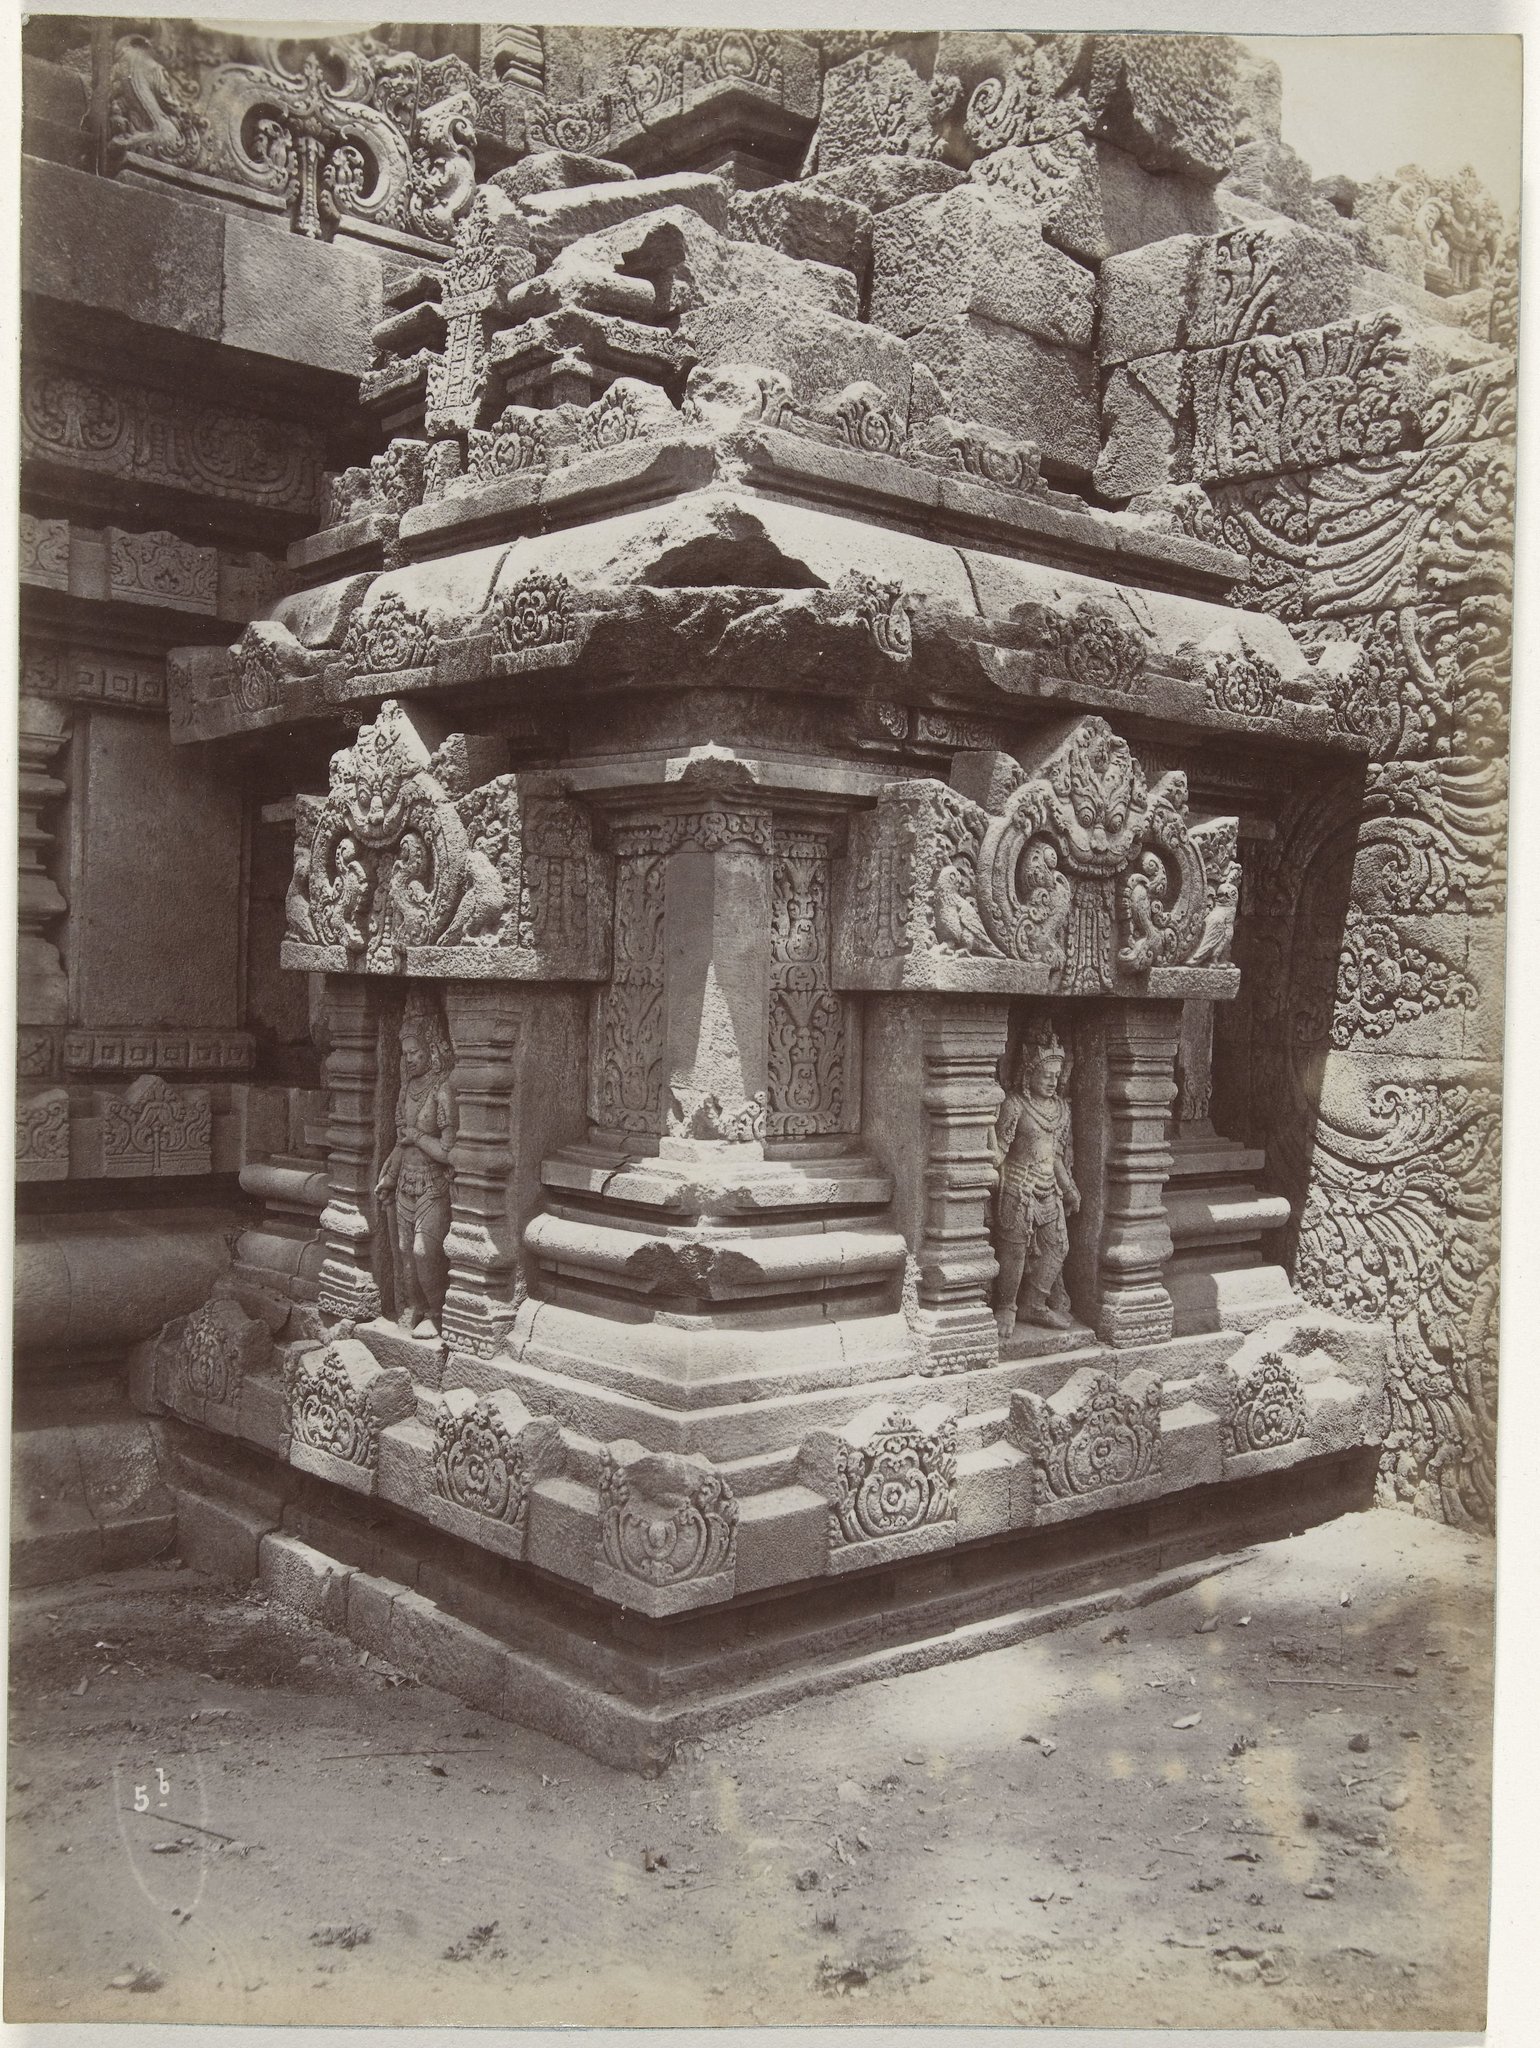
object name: photograph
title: Reliëf bij de noordelijke trap van de Shivatempel van het Prambanan-tempelcomplex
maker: kassian céphas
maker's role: fotograaf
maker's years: 1845-1912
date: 1889-1890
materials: paper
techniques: albumen print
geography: java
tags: temple, shrine ~ hinduism, buddhism, jainism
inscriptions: number: ‘5b’, inscription: ‘Tempel v. Brambanan/ (Boroboedoer)’